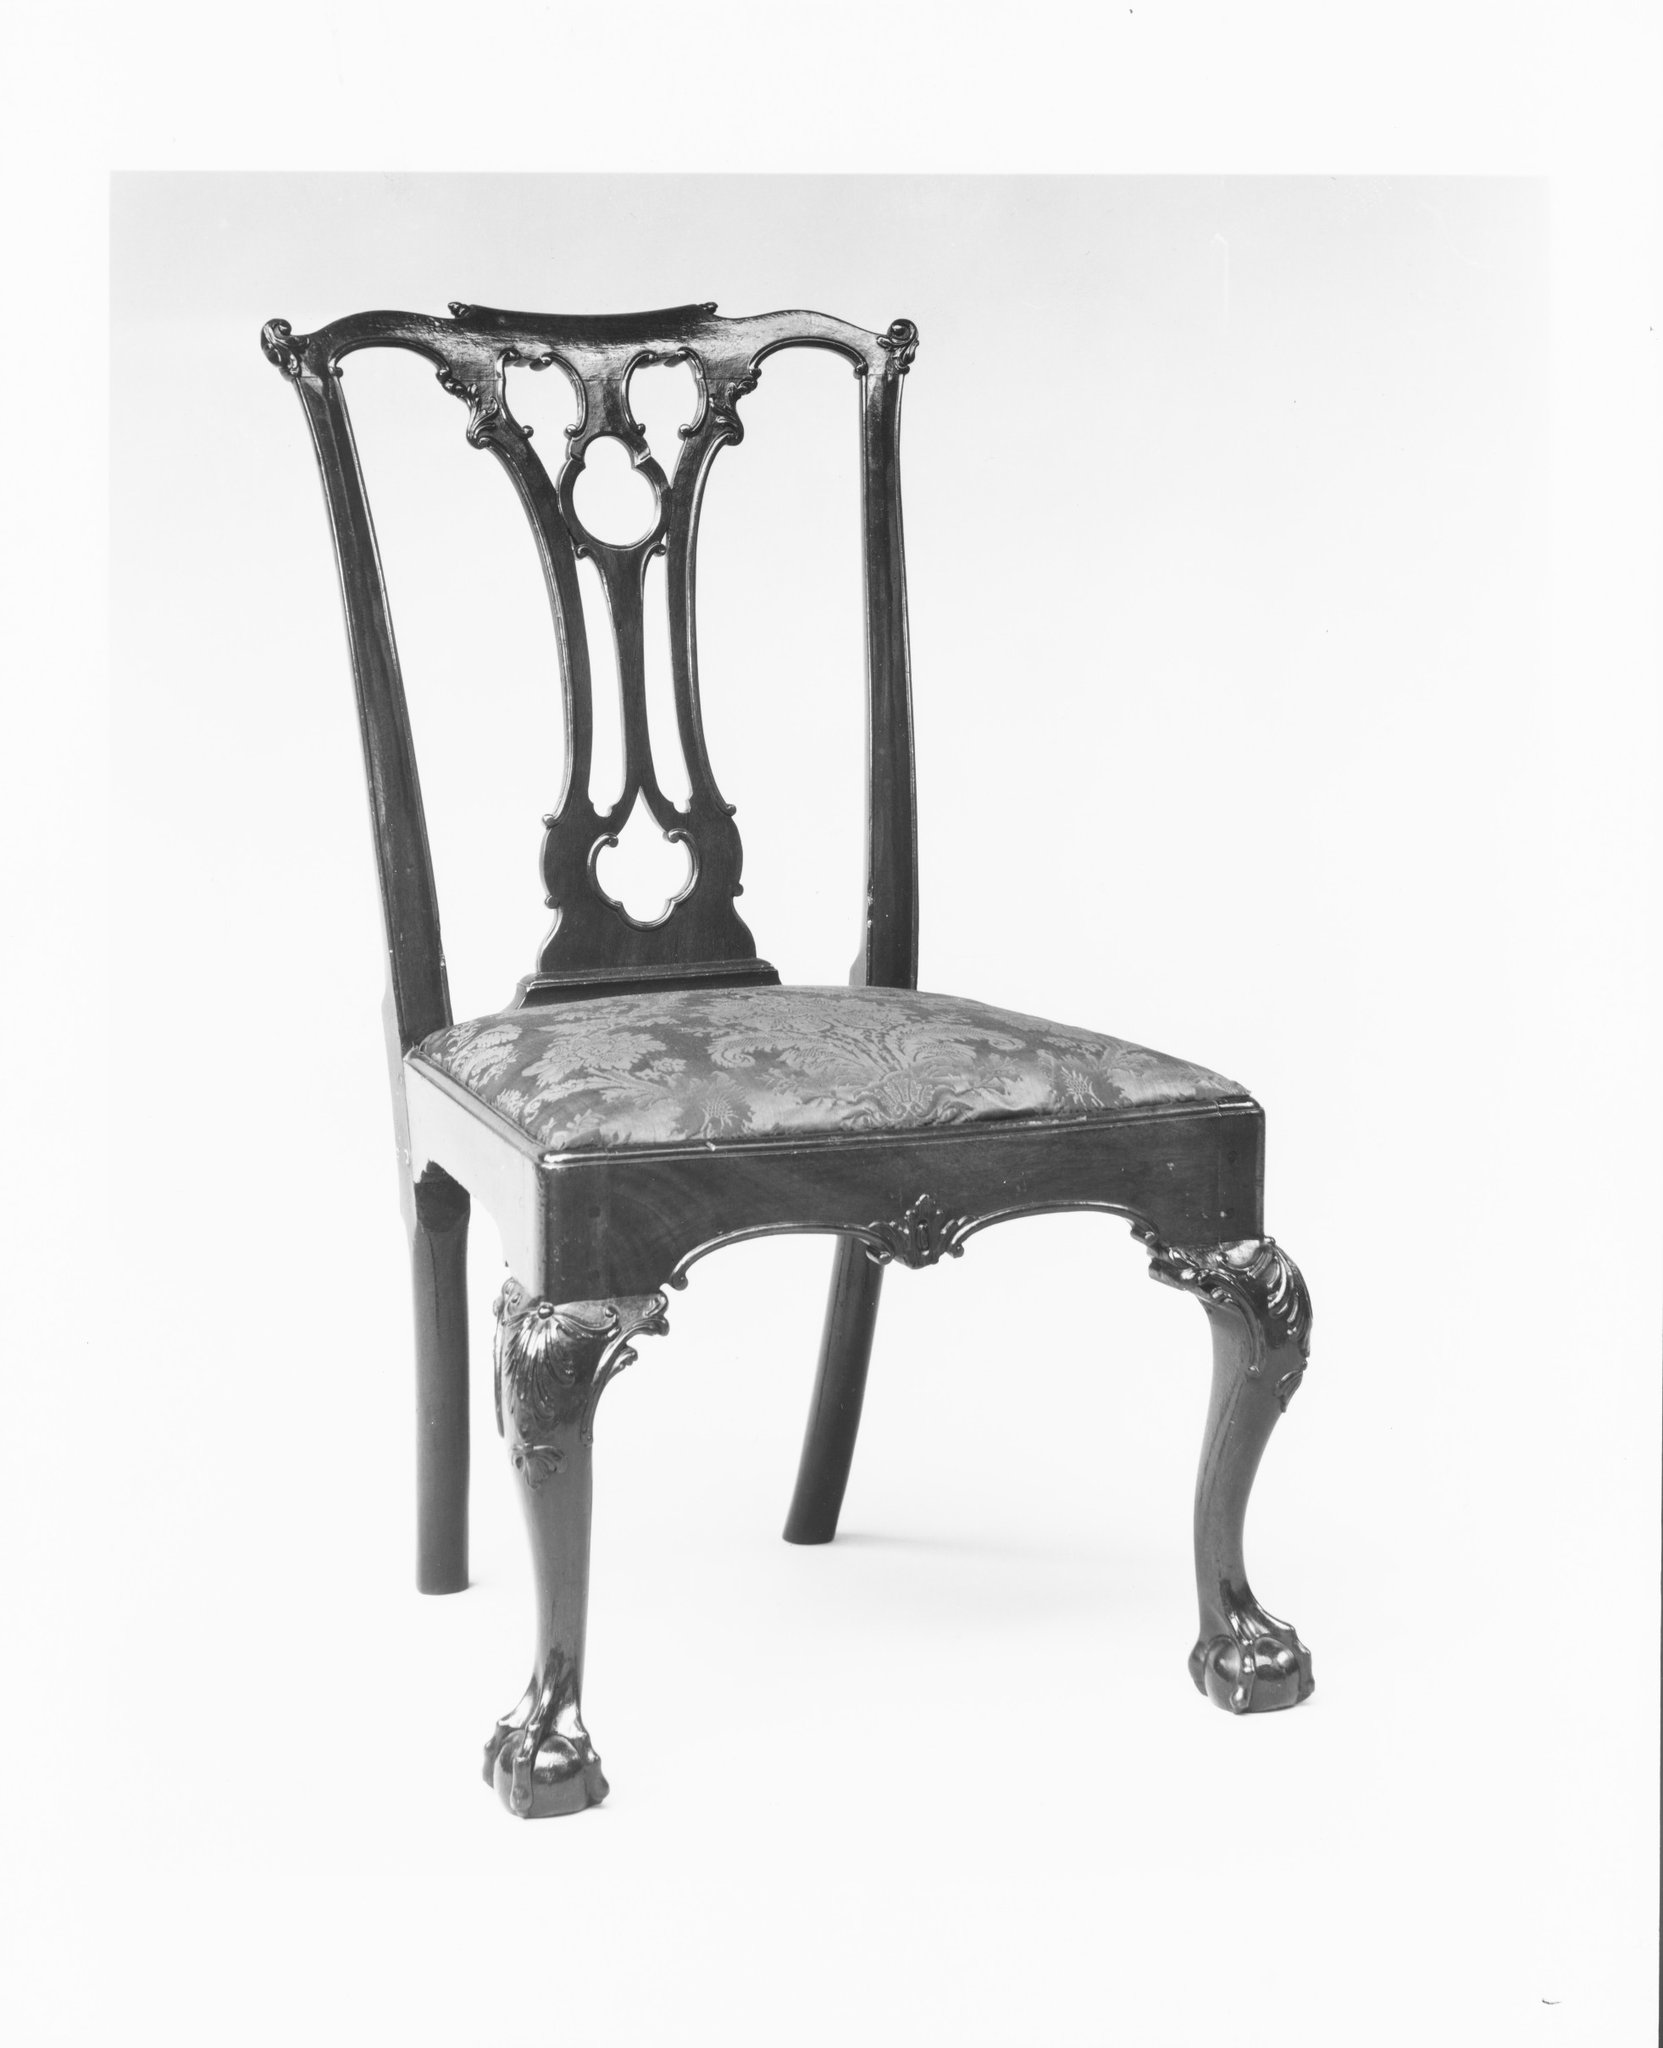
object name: side chair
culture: american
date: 1760-1790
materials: wood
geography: united states